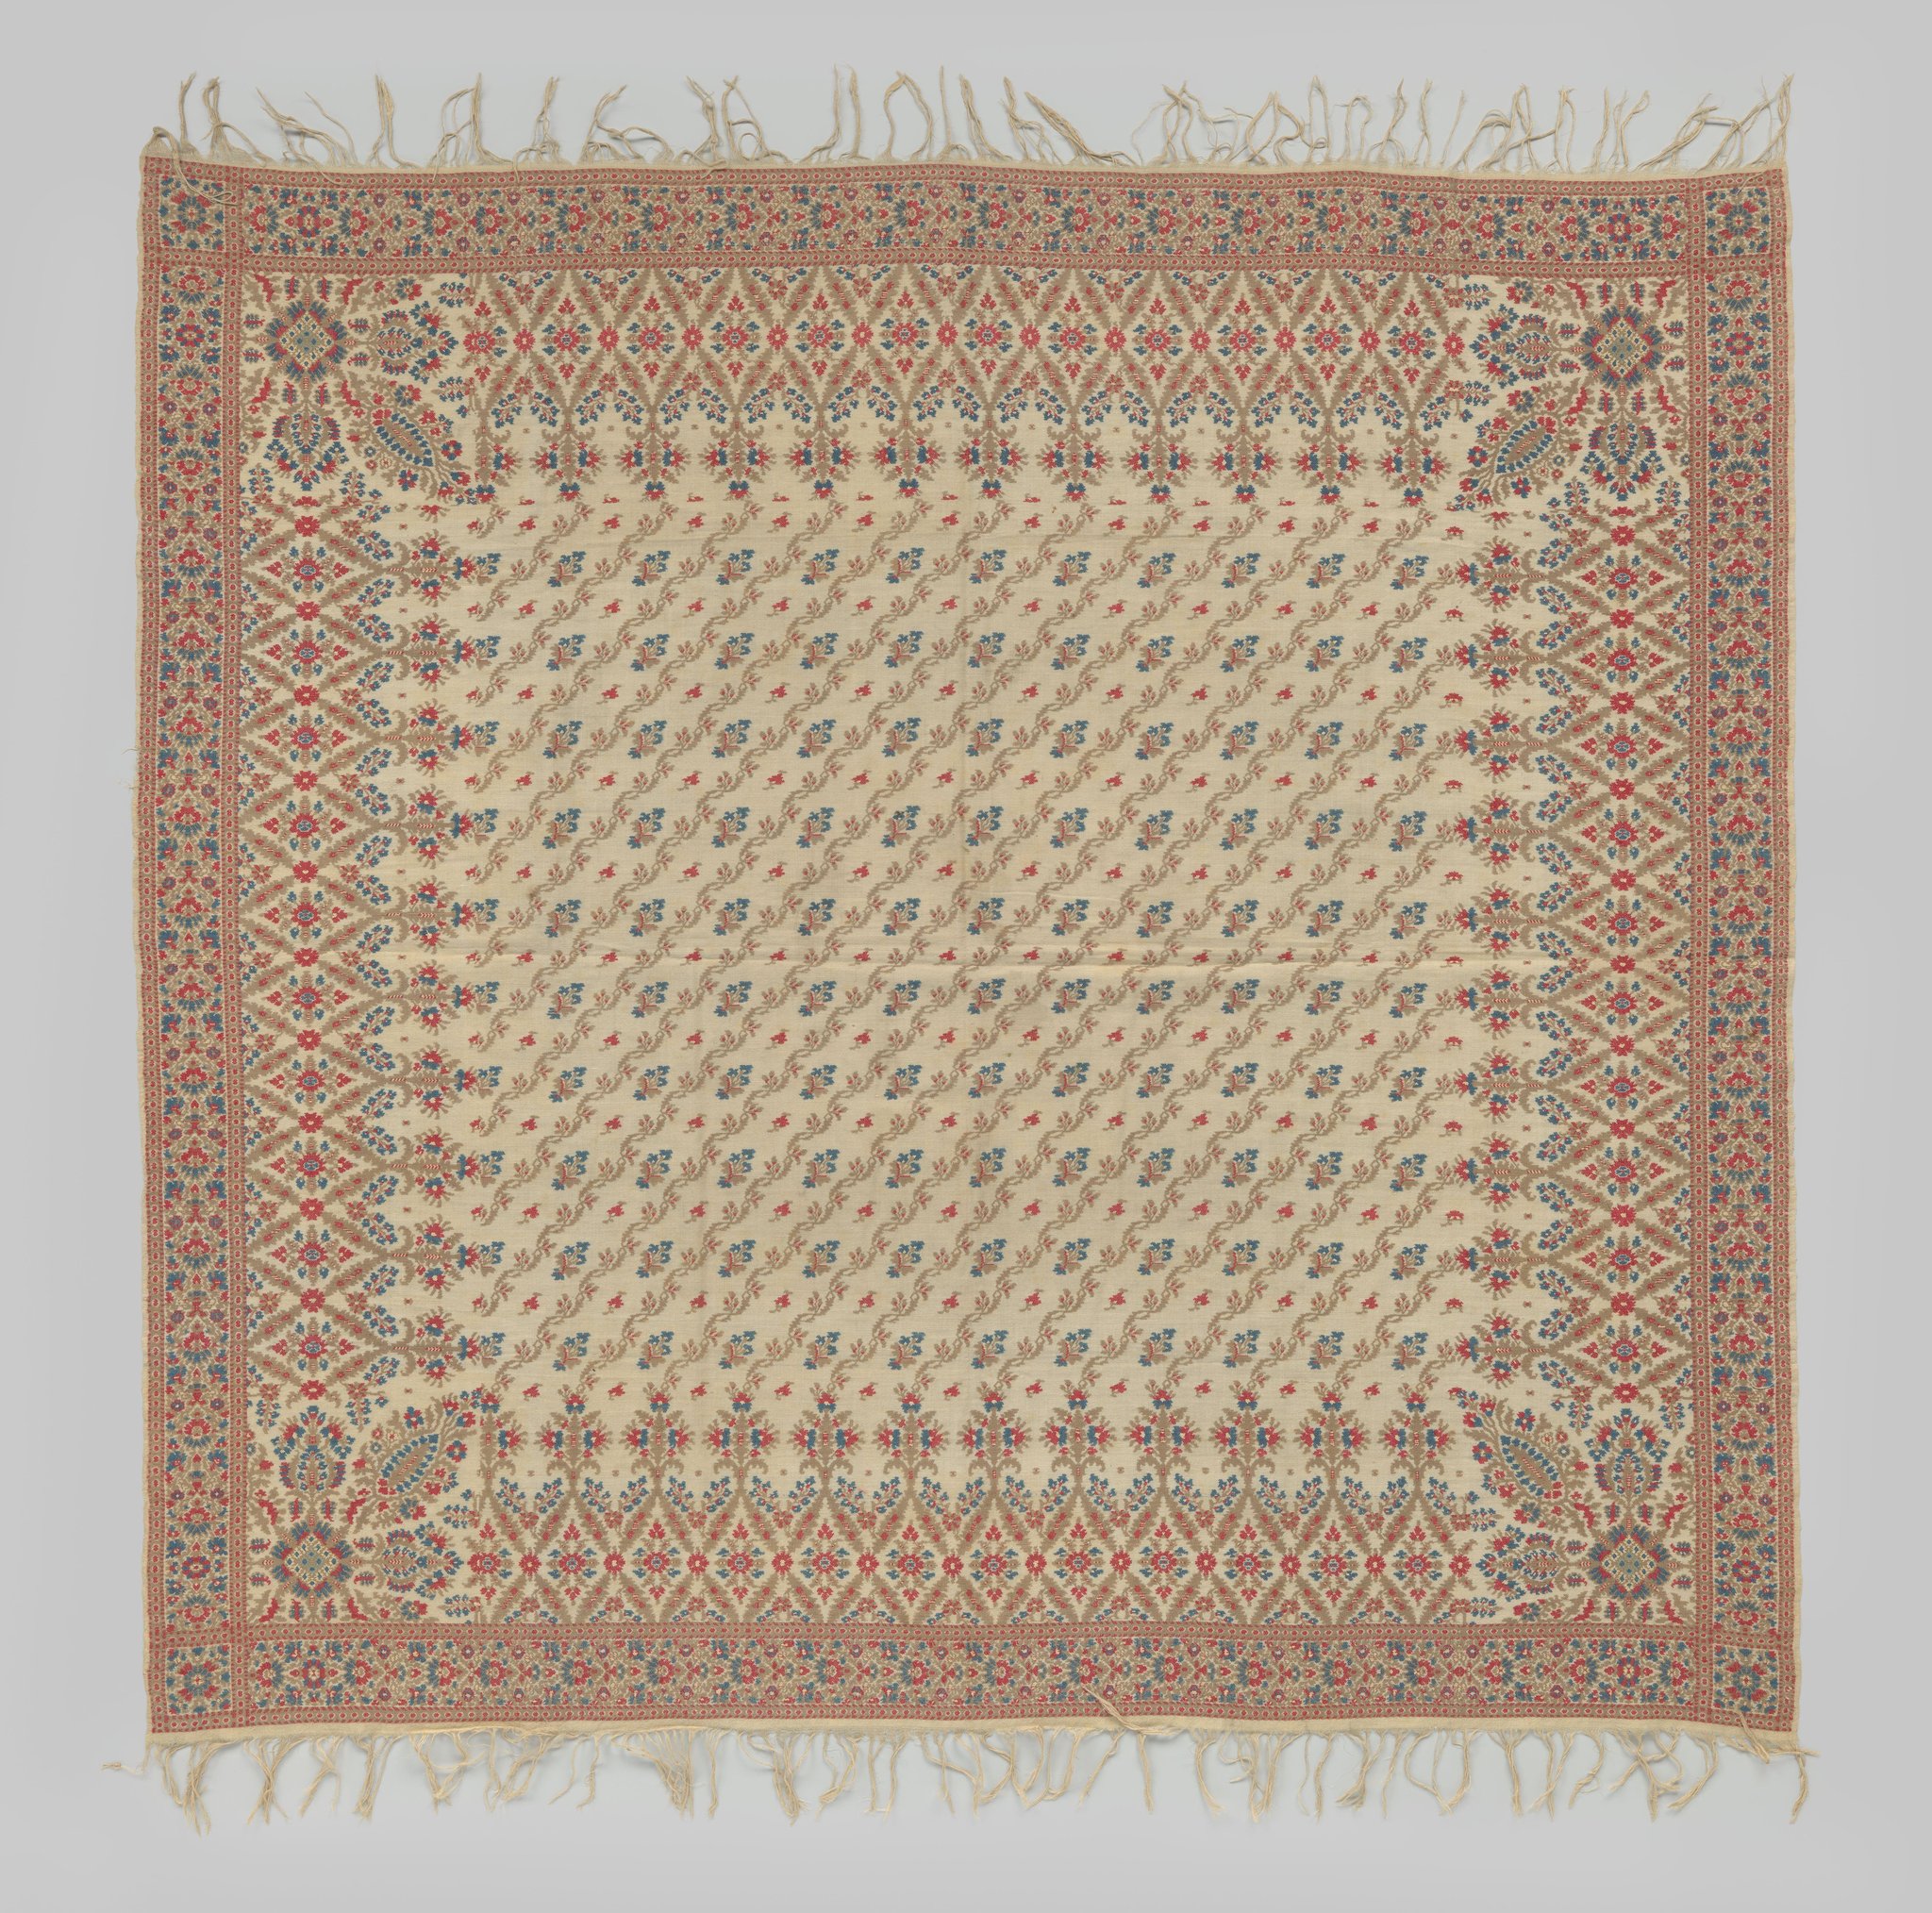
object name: clothing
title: Vierkante kasjmiersjaal, met rood, blauw en beige strooipatroon op wit veld en langs de rand een band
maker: Anonymous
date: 1830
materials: wool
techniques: weave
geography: norwich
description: Palmensjaal van geweven wol. Vierkant model met een wit fond in een volbestrooid veld en een dichter gevulde rand, alle in steenrood, ultramarijblauw en beige, hier en daar met glanzender witte punten. Het middenpatroon heeft een asymmetrisch decor van schuin rechts opgaande rijen van blauwe trosbloem en kleinere rode bloem. Daartussen diagonaal gerichte beige slingers met roos drieblad. Tegen de veldrand staan in beige ruiten geschikte randen met binnenwaartse drievoudige bloemtakken, blauwe hyancinten en rode rozetknoppen. Als hoekvullingen dragen de iets meer dan een kwart sterbloemen op de diagonaal een grote en rechte peervormige bloem, met op de kruisassen gedrongener bloemen, alles in de drie kleuren. De smalle randen hebben symmetrische bloemen om de randmiddellijn. Vatting van smalle lijsten die elkaar op de hoeken oversnijden en daar een vierkant met één sterbloem vormen. De techniek bestaat uit een wollen ketting met inslag, in keperbinding van 2/2 geweven. Aan de achterzijde zijn de inslagdraden flottant gelaten, maar ook afgesneden (?). In een 26 cm brede bovenrand verspringt de keper.